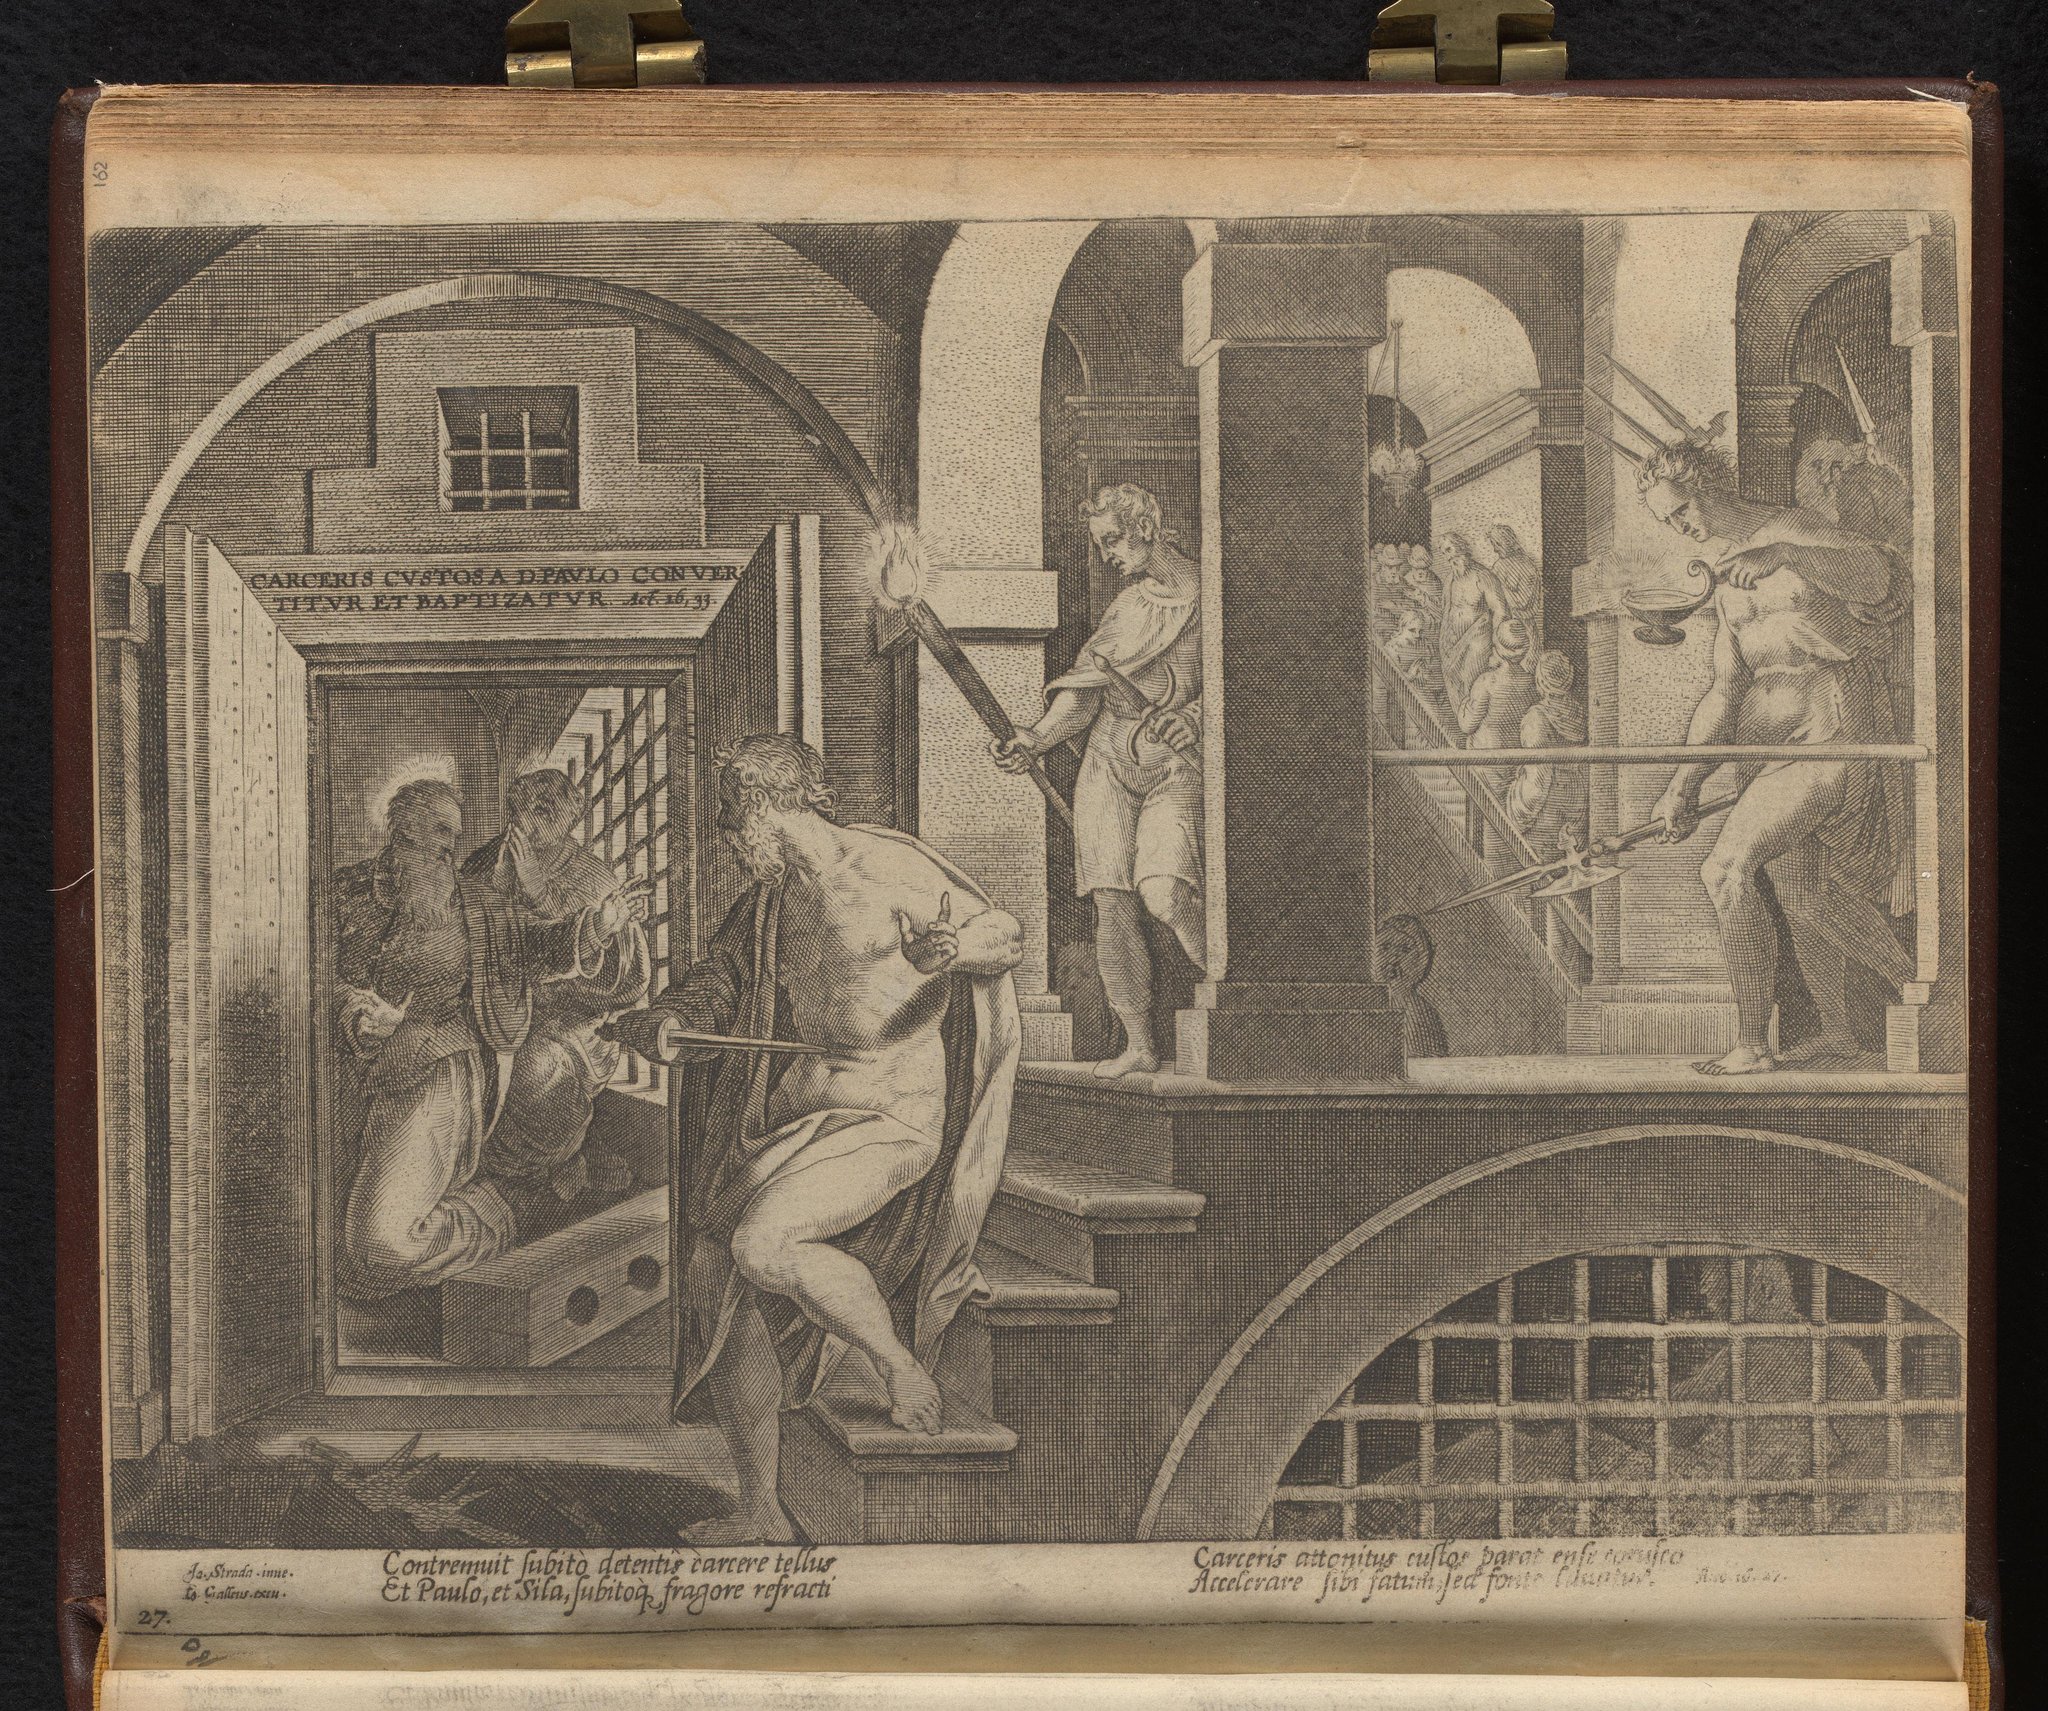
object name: titelprent, frontispice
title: Bekering van de gevangenenbewaarder van Filippi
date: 1582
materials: paper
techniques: engraving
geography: antwerp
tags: paul and silas prevent the warder from committing suicide (story of the conversion of the warder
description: Prent maakt deel uit van een prentbijbel.